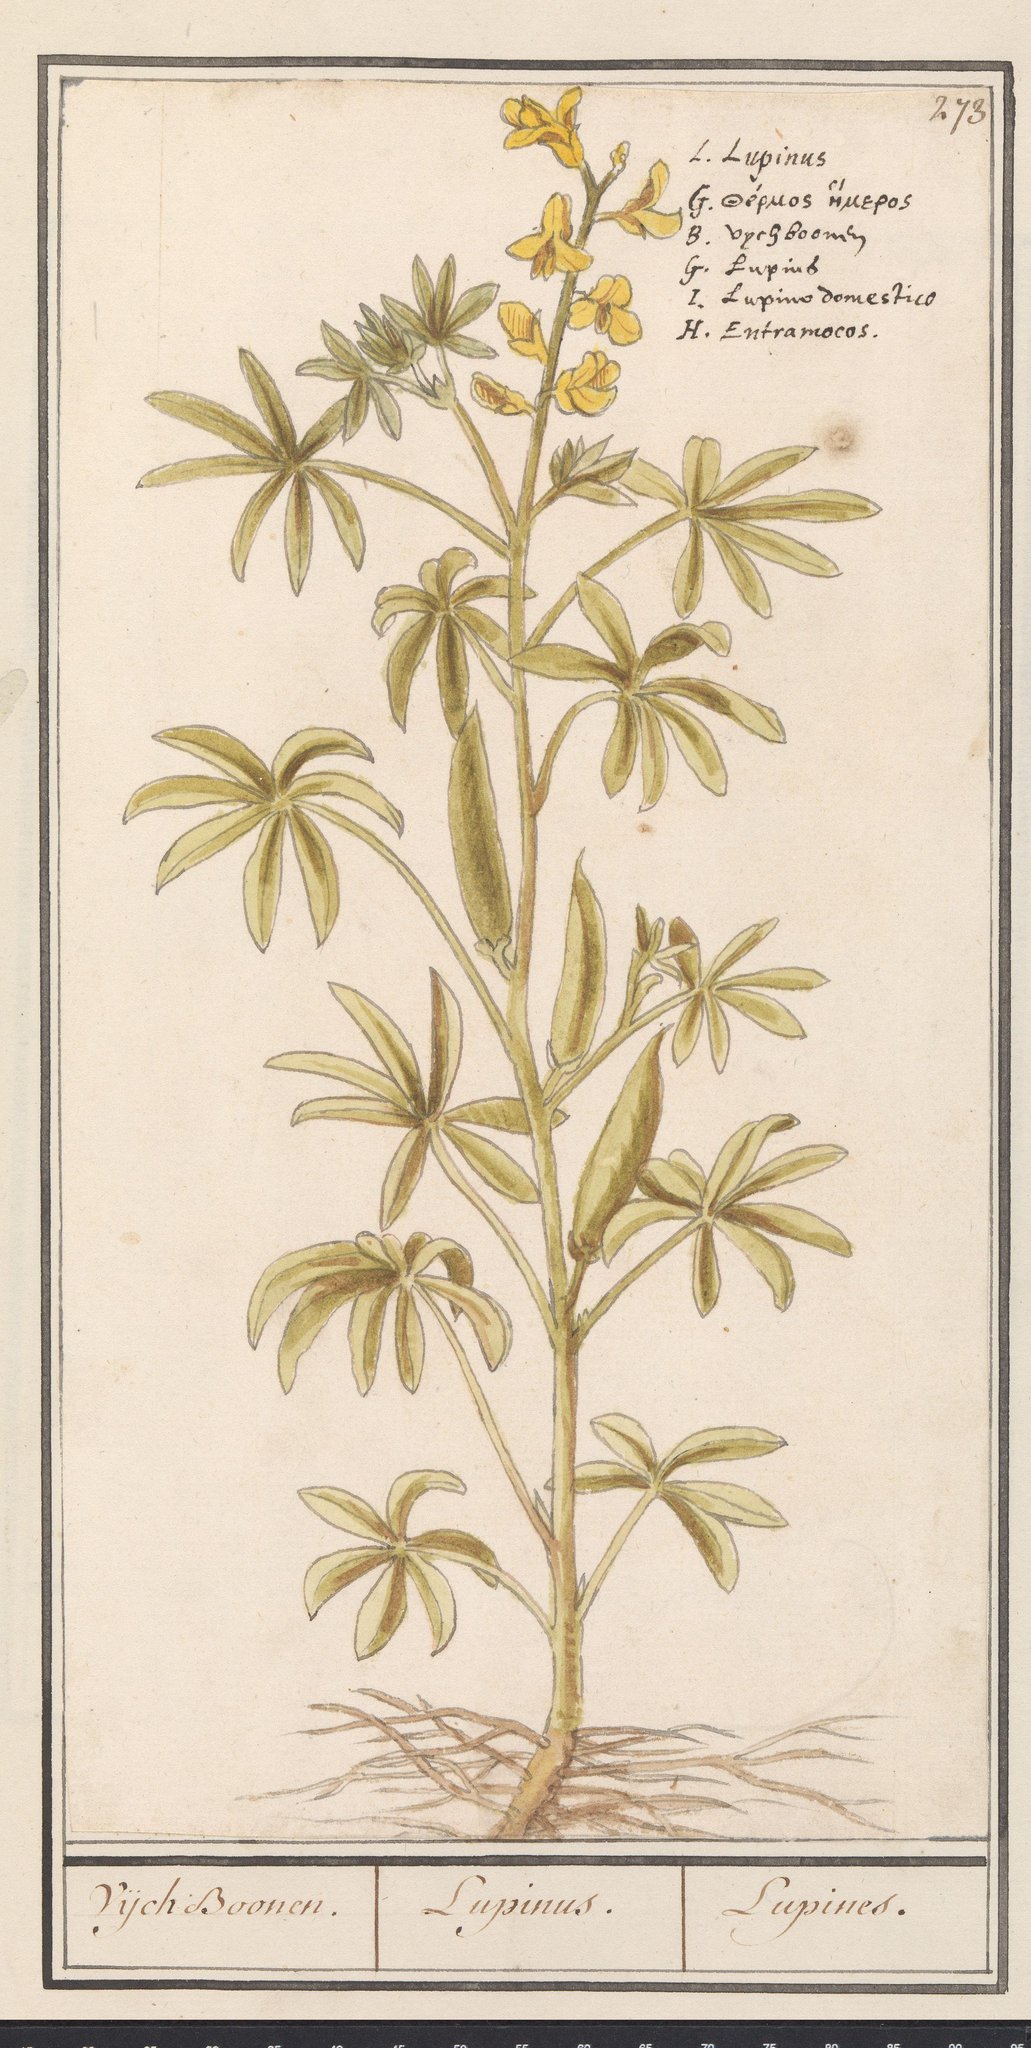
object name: drawing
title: Lupine (Lupinus)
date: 1596-1610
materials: chalk, paint, ink, paper, watercolor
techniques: brush, pen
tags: flowers: lupin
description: Wilde lupine. Genummerd rechtsboven: 273. Hierbij ook de naam in zes talen. Onderdeel van het derde album met tekeningen van bloemen en planten. Tiende van twaalf albums met tekeningen van dieren, vogels en planten bekend rond 1600, gemaakt in opdracht van keizer Rudolf II. Met toelichting in Nederlands, Latijn en Frans.